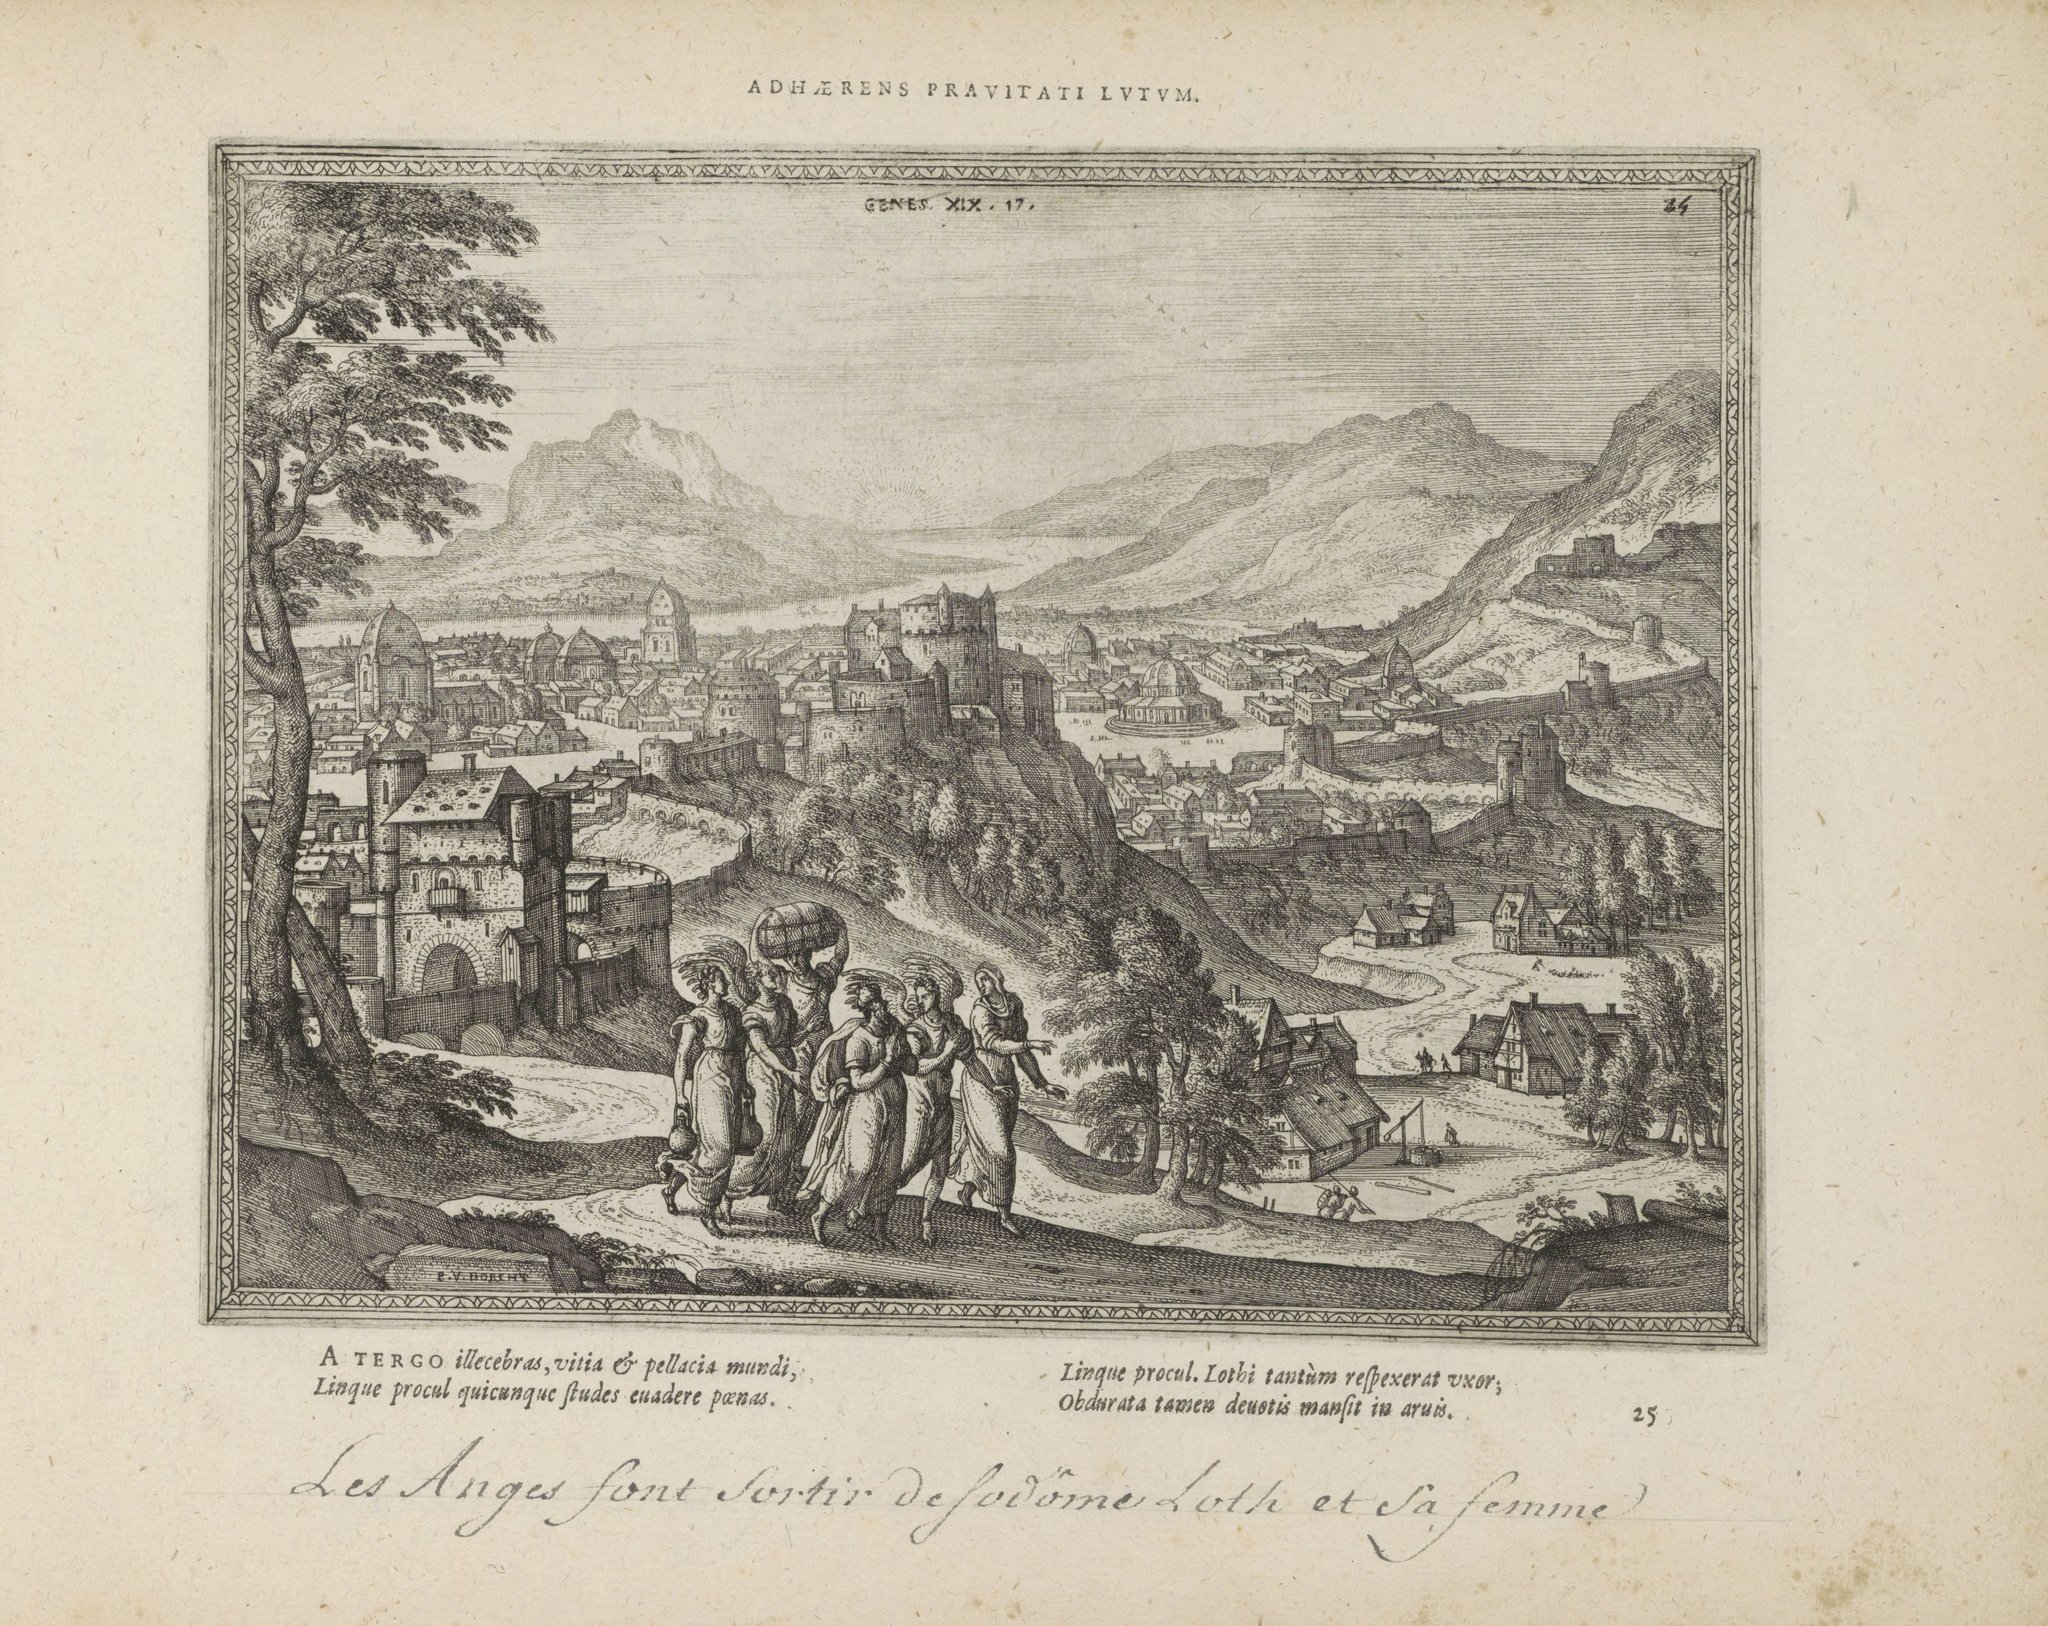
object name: album leaf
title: Adhaerens pravitati lutum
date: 1582-1593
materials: paper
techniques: etching, letterpress printing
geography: amsterdam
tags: the destruction of sodom and gomorrah: lot and his family flee to zoar, carrying their belongings; an angel may be showing the way (genesis 19:24-29)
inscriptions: inscription: ‘Les Anges sont sortir de sodome Loth et sa femme’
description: Lot verlaat met zijn dochters de stad Sodom. Ze worden begeleid door twee engelen (Gen. 19:17). Met een motto in het Latijn boven de voorstelling en een vierregelig onderschrift in het Latijn onder de prent. De prent maakt deel uit van een album.